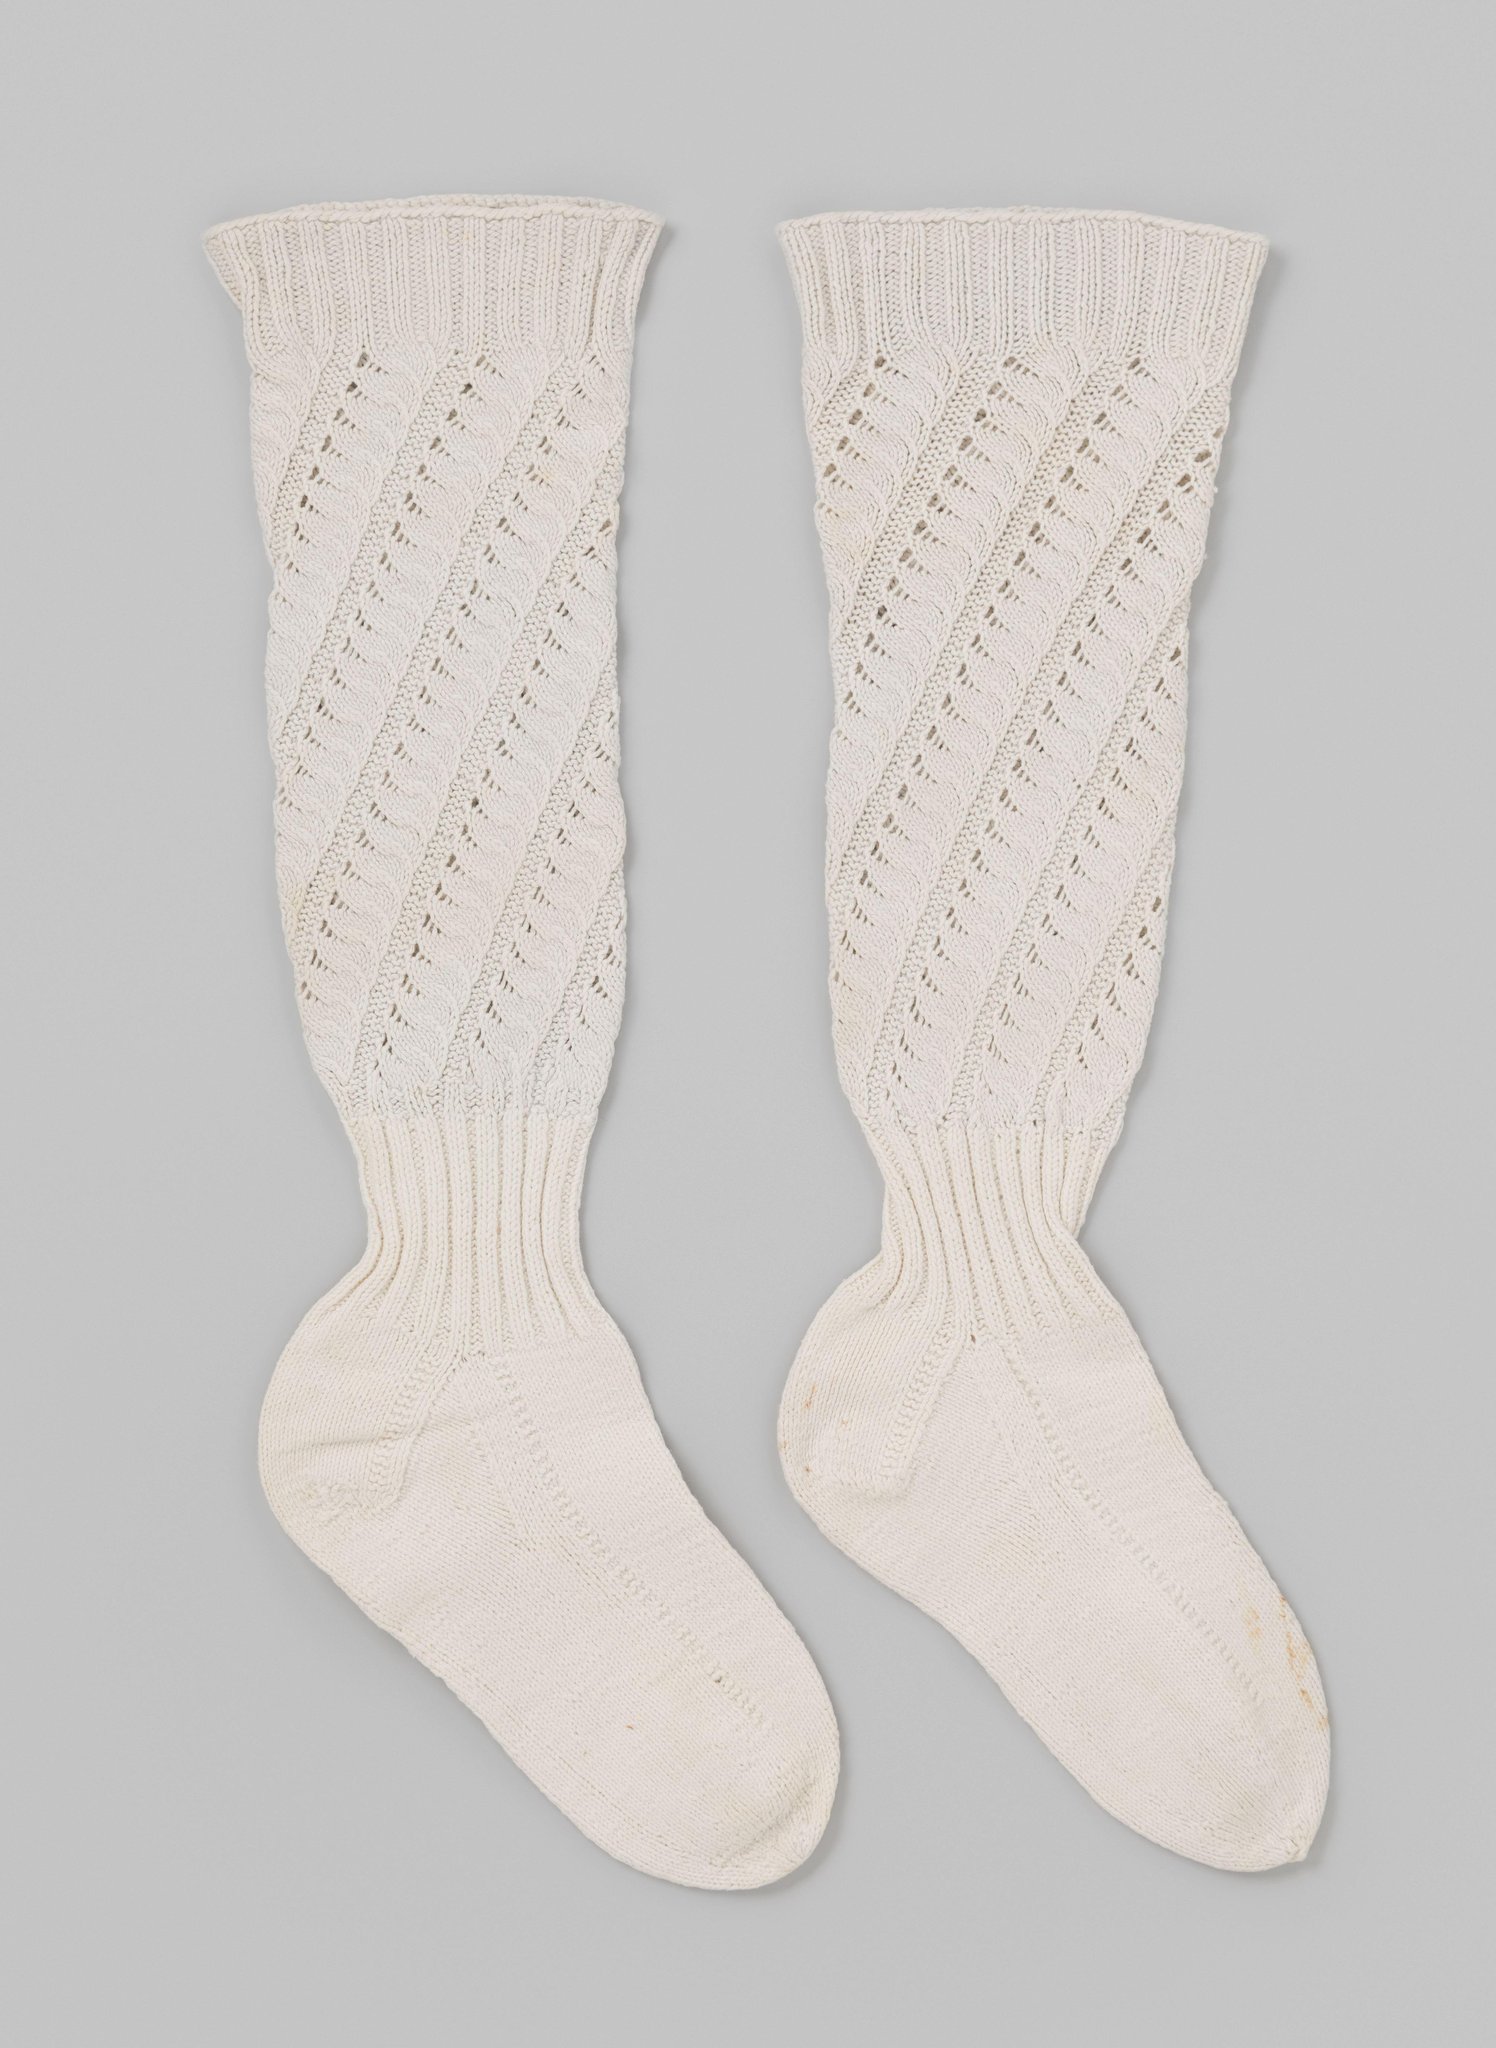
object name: stocking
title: Kous van witte katoenen tricot, met diagonaal patroon van slingerende banen, smalle boord en versmalling rond de enkel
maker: Anonymous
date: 1830-1840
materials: cotton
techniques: knitting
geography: netherlands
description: Kous van dikke witte katoenen tricot, met diagonaal patroon van slingerende banen, smalle boord en versmalling rond de enkel. Voet en enkel deel zijn aangebreid, te zien aan het lichte kleurverschil.